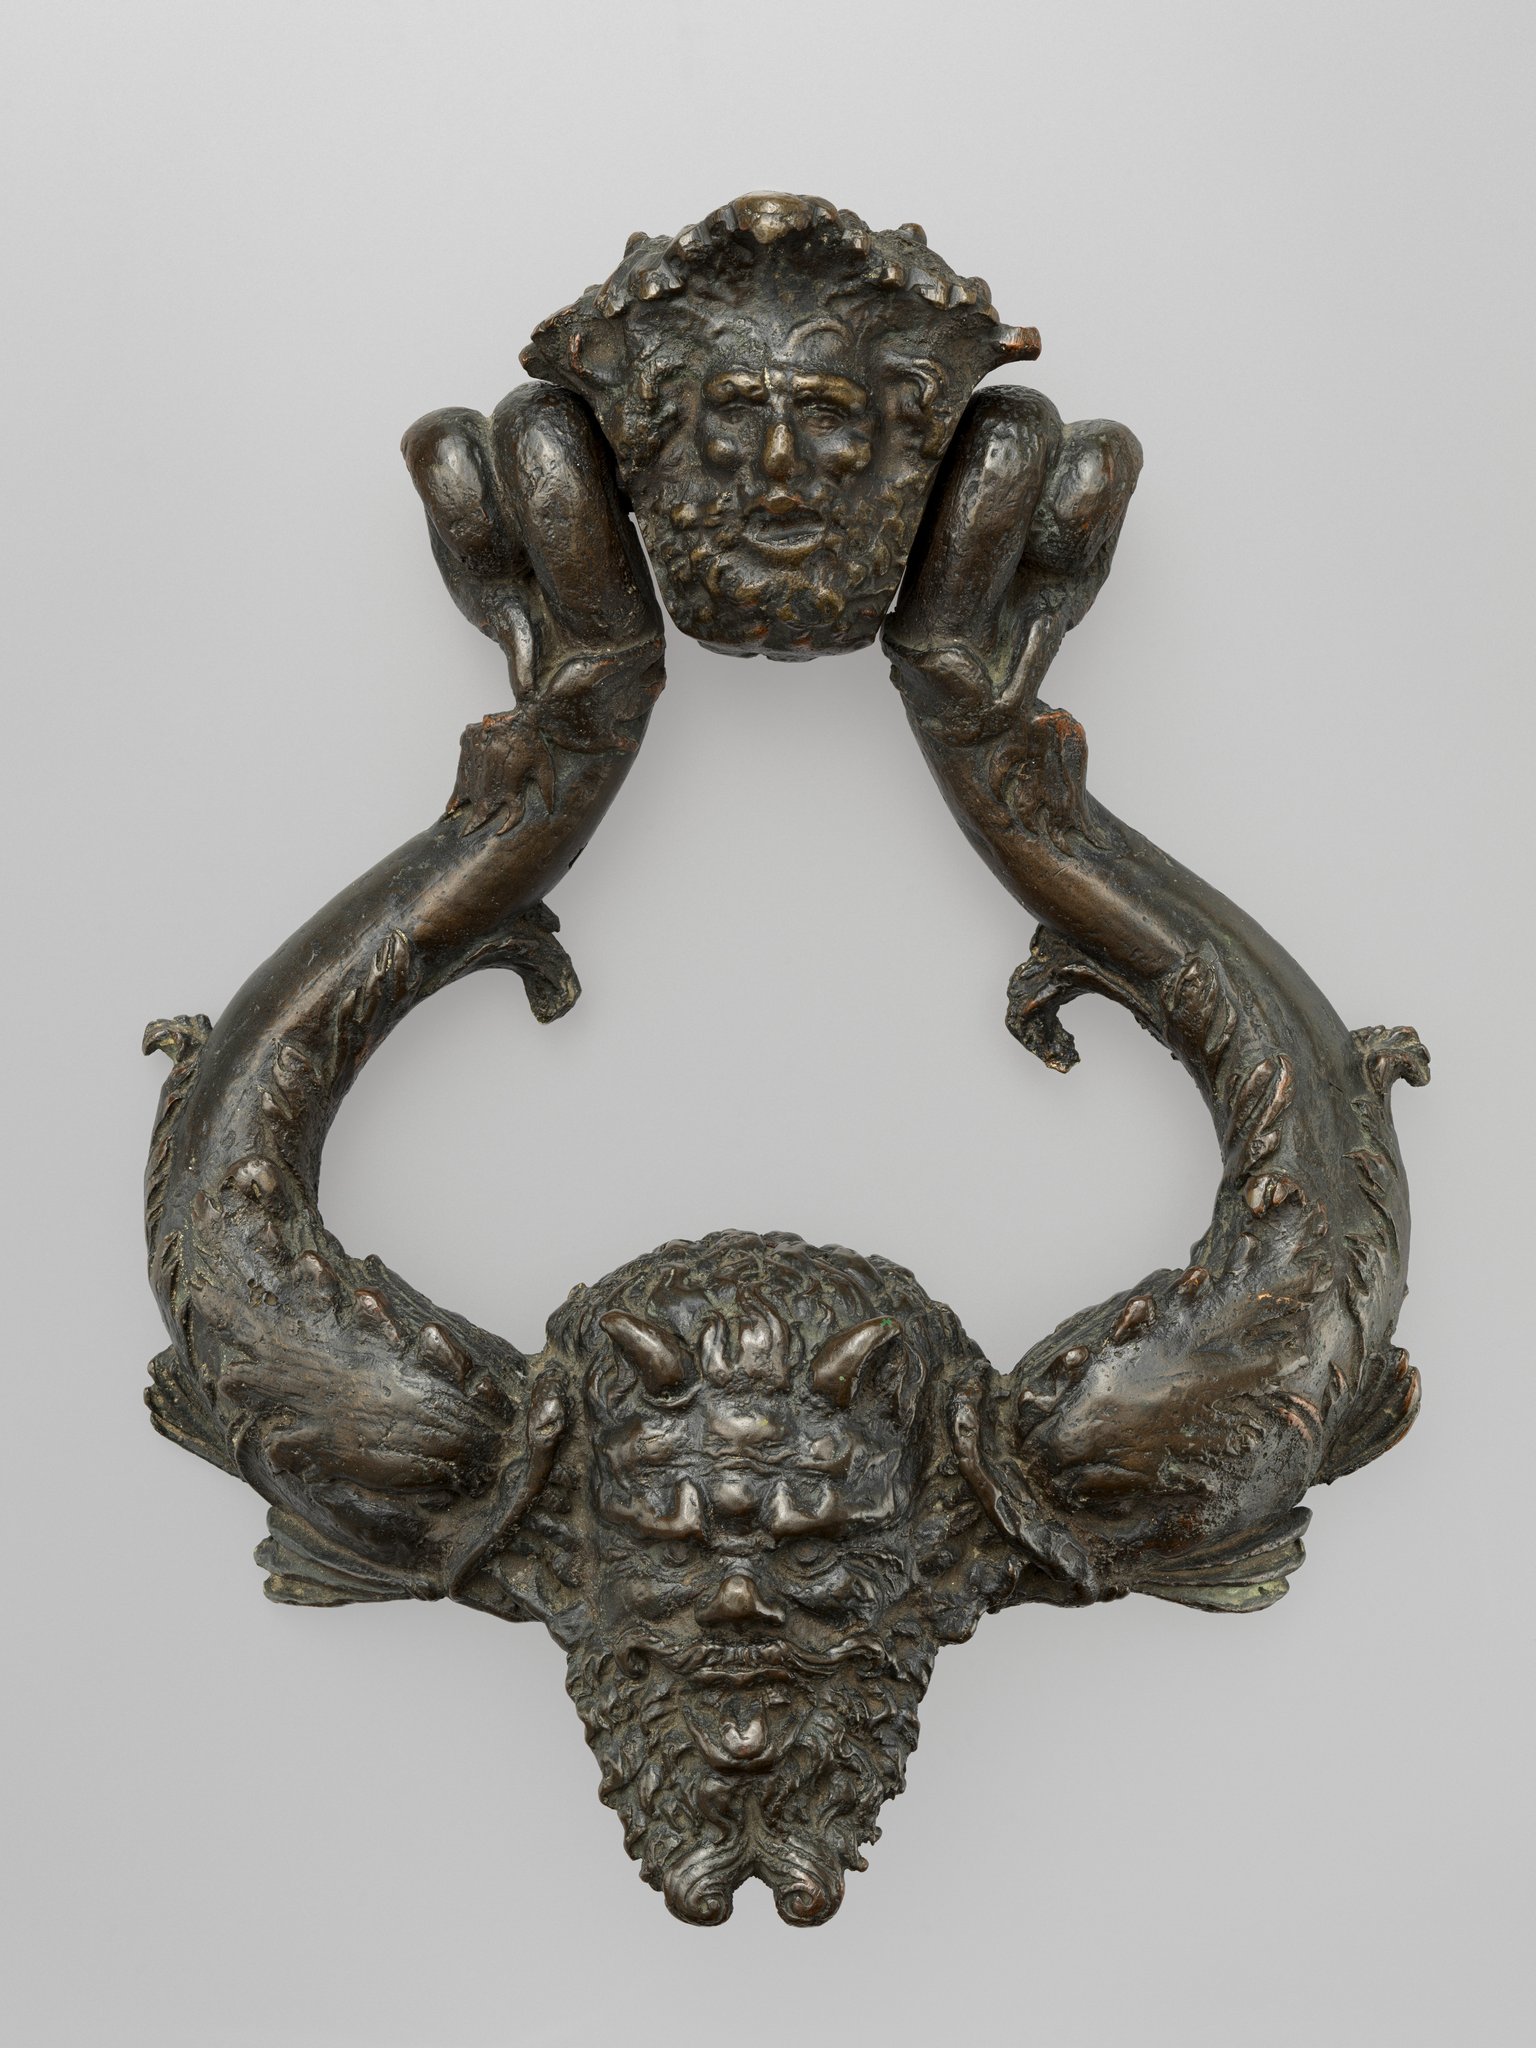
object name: door knocker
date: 1550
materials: bronze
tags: masks,dolphins